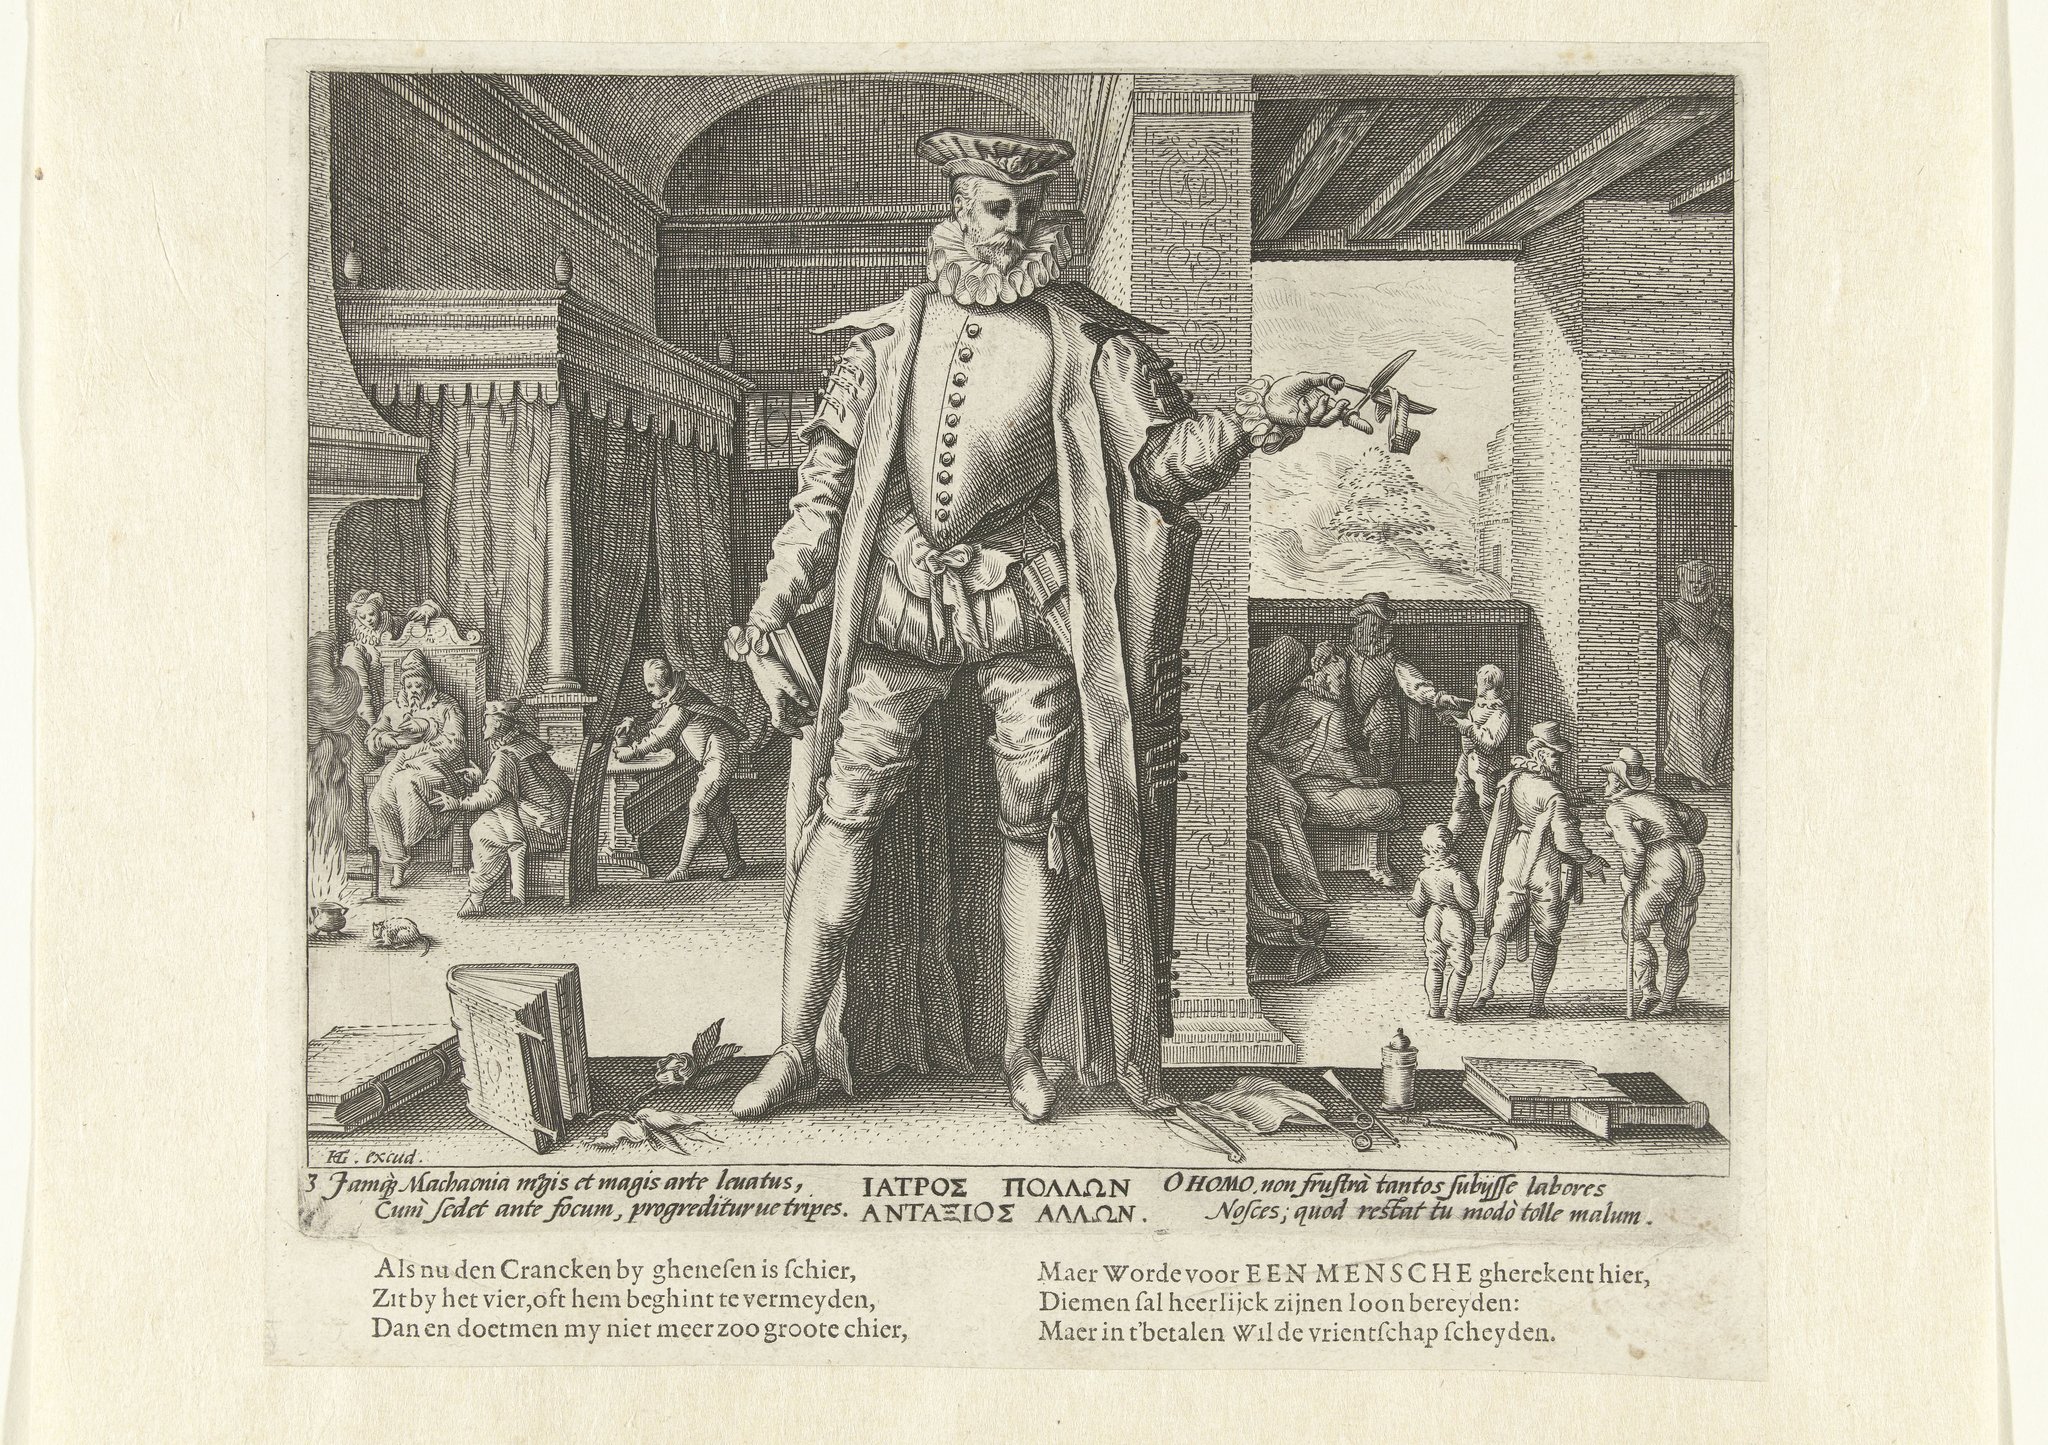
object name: print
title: De arts als mens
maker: hendrick goltzius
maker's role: draughtsman, painter, print maker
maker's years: 1558-1617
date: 1587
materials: paper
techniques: engraving, letterpress printing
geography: haarlem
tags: physician, doctor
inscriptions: caption: ‘Jamq Machaonia magis...tolle malum’, number: ‘3’, caption: ‘Als nu den Crancken...vrientschap scheyden’, collector's mark: Lugt 240, signature: ‘HG. excud.’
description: In een huis zit een man bij de haard naast zijn bed, familieleden zorgend om hem heen. Een arts zit pratend naast hem. In het vertrek daar rechts naast is te zien wat er gebeurd is met de man sinds zijn val (zie de eerste twee prenten van de serie): zijn hoofdwond is verzorgd en hij heeft op krukken gelopen. Op de voorgrond nogmaals de arts, staand te midden van boeken en medische instrumenten. Onder de voorstelling gegraveerde Latijnse en Griekse teksten en (buiten de plaatrand maar op hetzelfde blad) een gedrukte Nederlandse tekst, waarin wordt uitgelegd dat de arts als een gewoon mens wordt behandeld als de zieke bijna genezen is. Deze prent is onderdeel van een serie van vier prenten waarop verbeeld is hoe de arts beschouwd en gewaardeerd wordt tijdens zijn bezoek aan een zieke: bij binnenkomst als een god, na de eerste hulp als een engel, bij genezing als een mens en wanneer er betaald moet worden als een duivel.